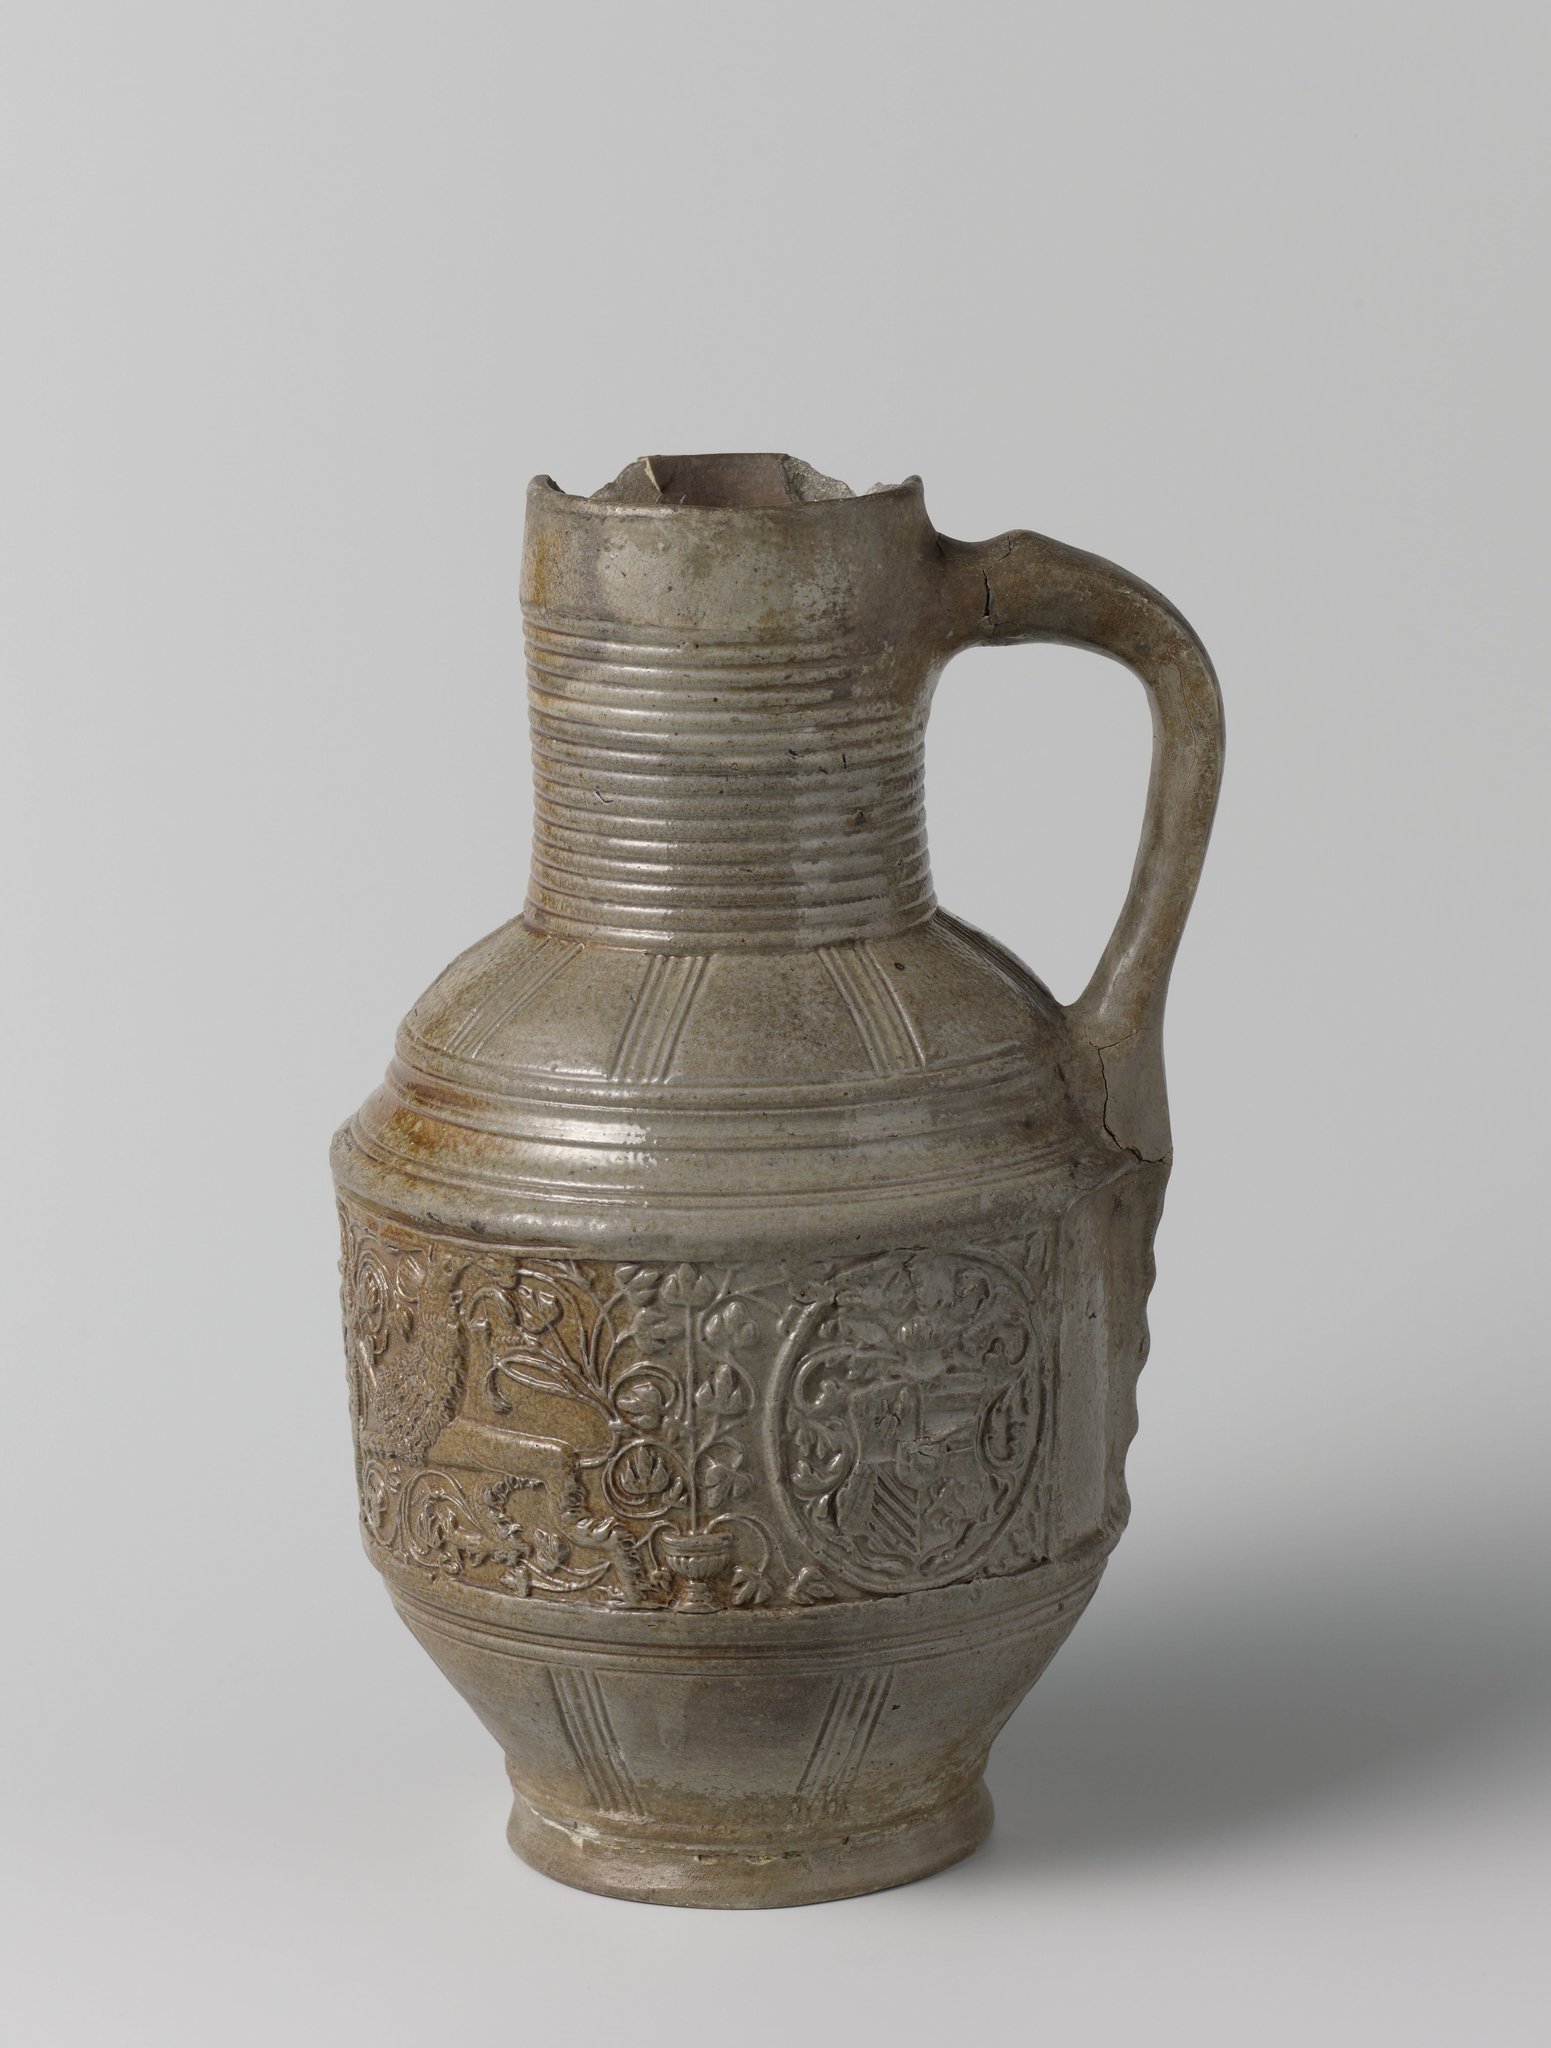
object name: jug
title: Jug with coat of arms in medallions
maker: Anonymous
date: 1550-1599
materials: glaze, stoneware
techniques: firing, forming, relief, turning, vitrification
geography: raeren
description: Kruik van steengoed op standring met een cilindervormig lichaam met ronde schouder en wijde, geribde nek. Het C-vormige oor is bevestigd aan de nek en de schouder. Op de buik in reliëf drie gedrukte en opgelegde medaillons met in elk een ander wapen. Het middelste medaillon wordt geflankeerd door leeuwen en bladranken. De schouder en het onderste deel van de buik zijn verdeeld in ingegrifte vakken. Raeren.